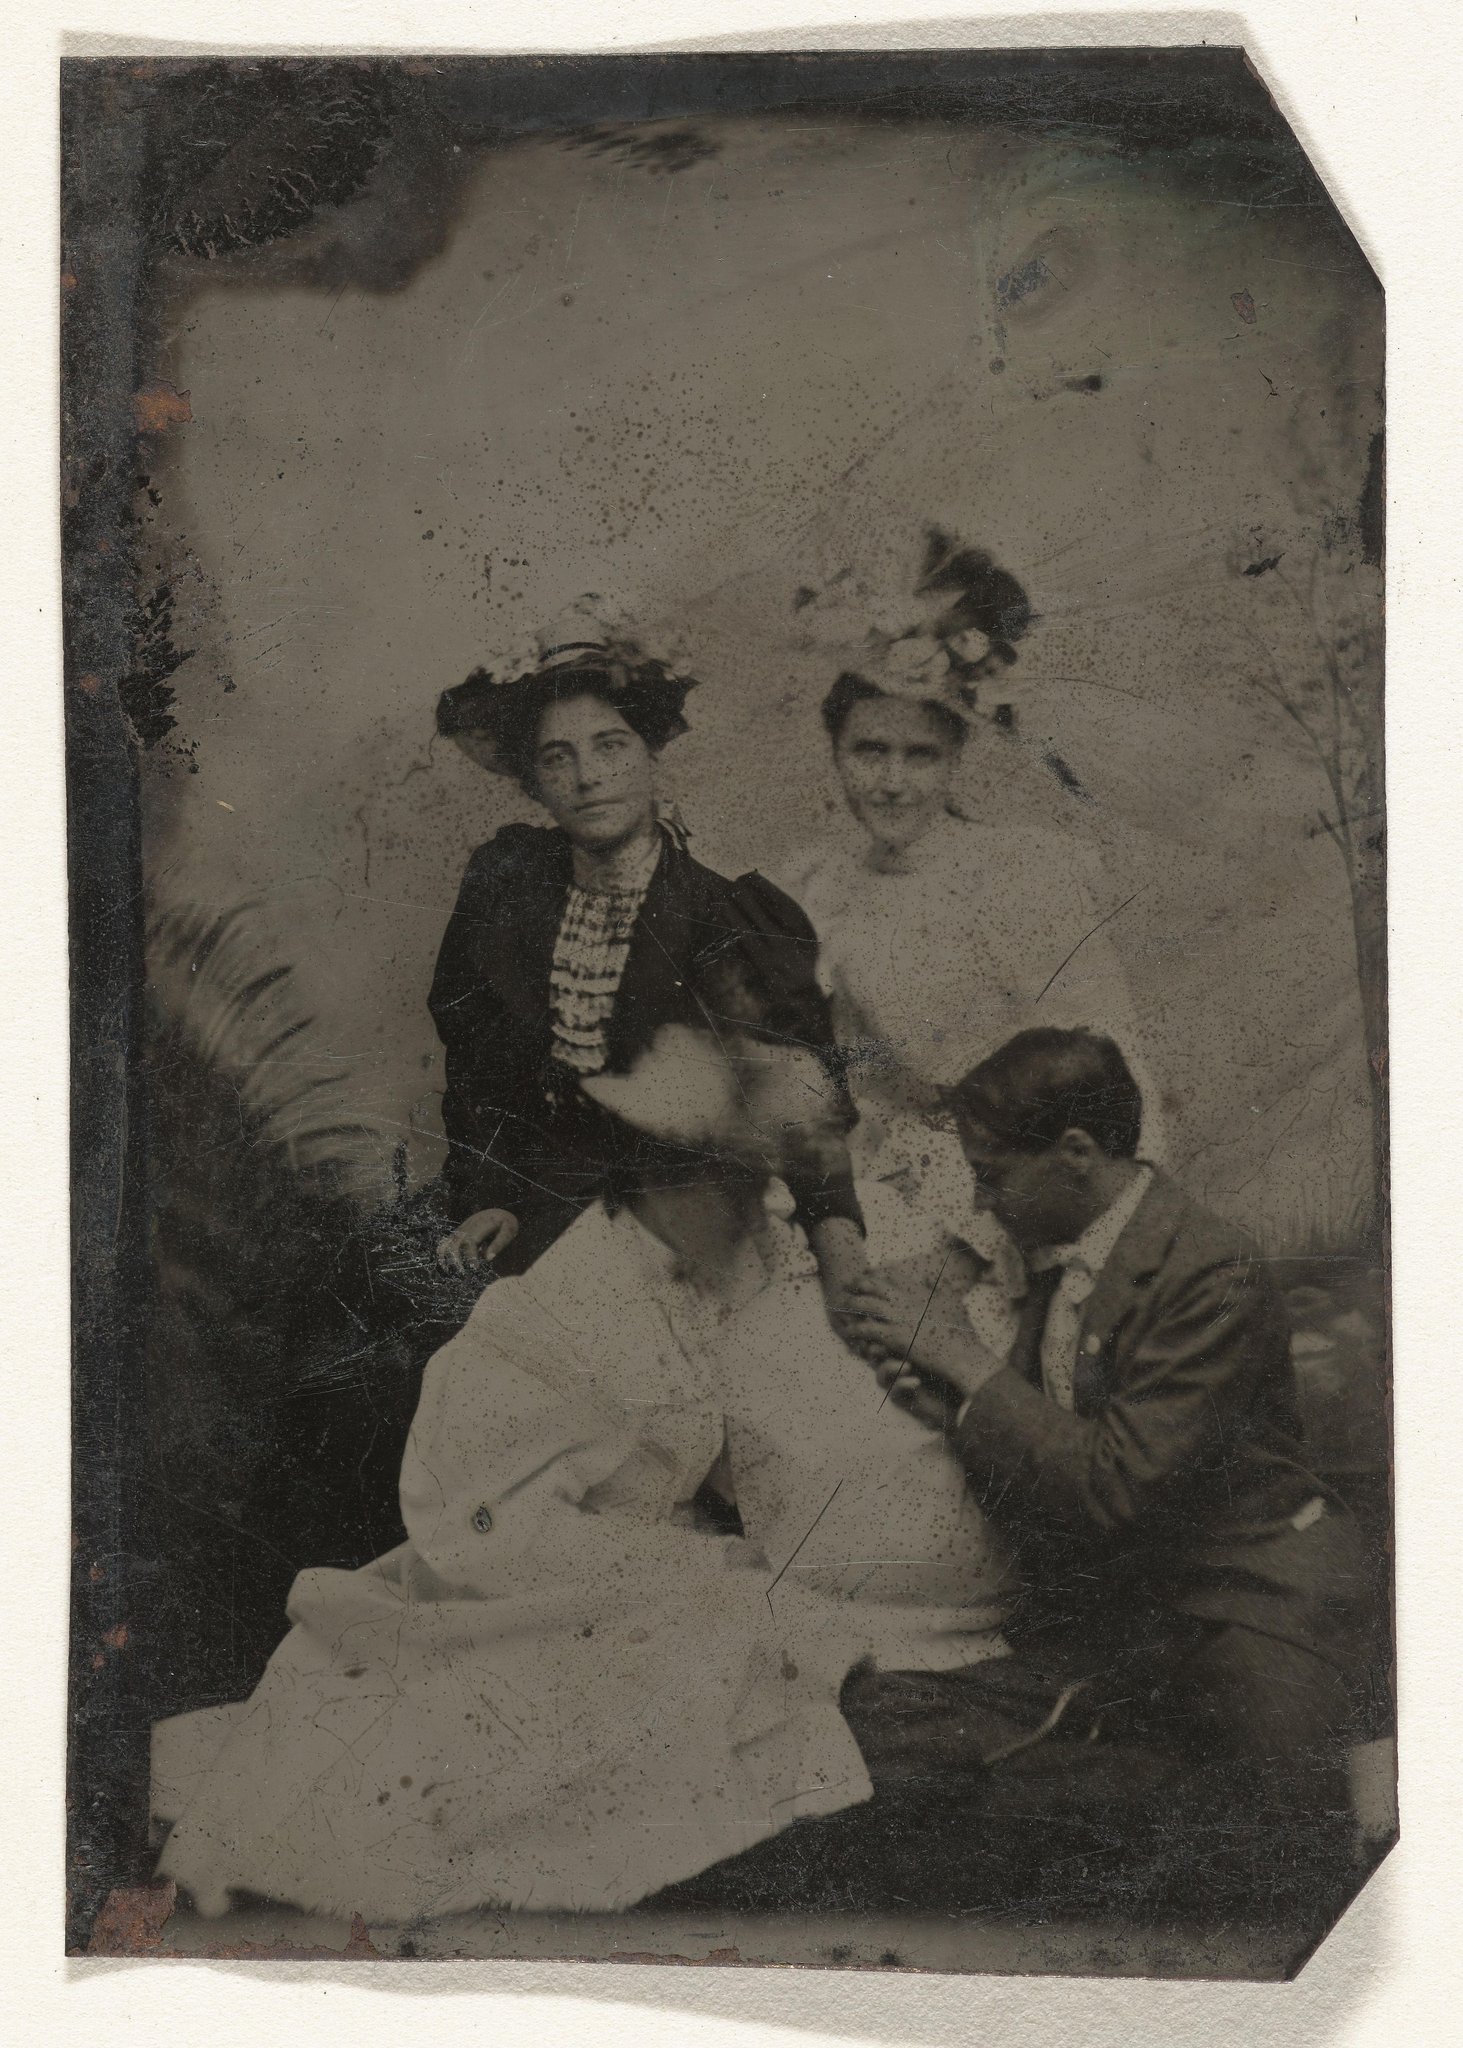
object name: photograph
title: Portret van een man die geknield zit bij drie vrouwen en van twee van hen een hand vasthoudt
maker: Anonymous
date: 1880-1910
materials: metal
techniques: ferrotyping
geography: united states